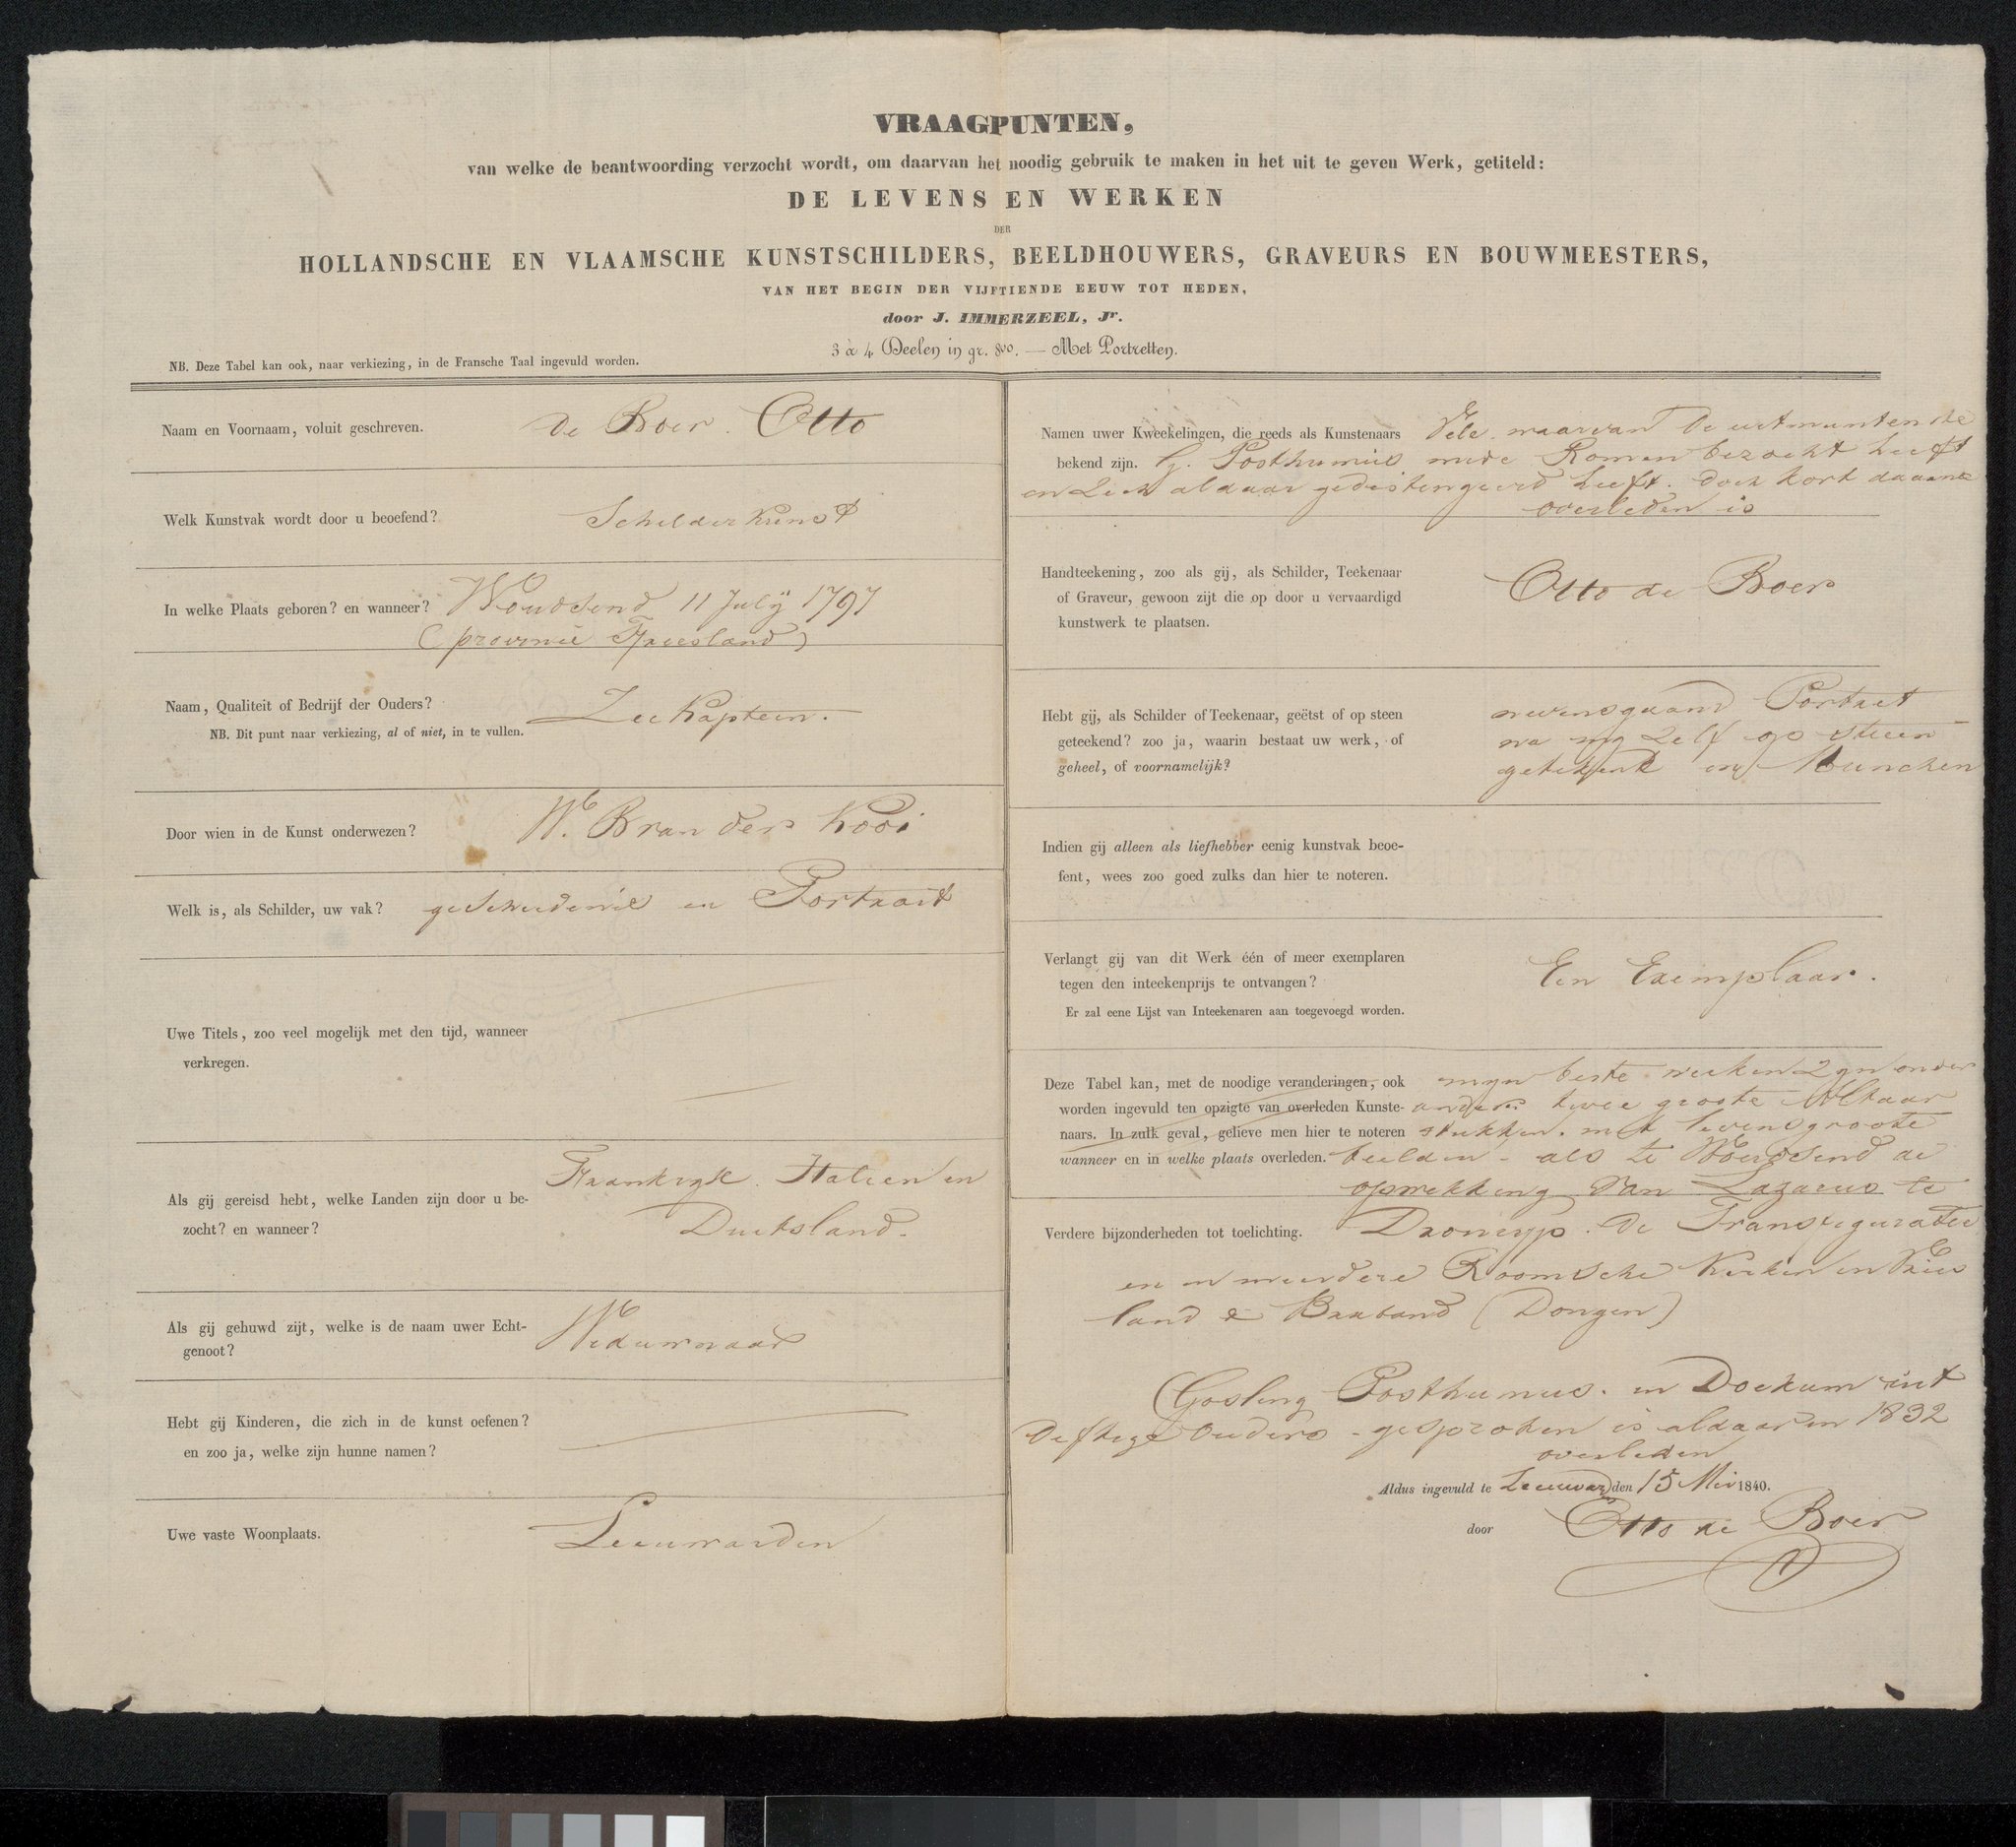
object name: questionnaire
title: Enquêteformulier ingevuld door Otto de Boer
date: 1840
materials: ink, paper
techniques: pen, printing, writing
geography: leeuwarden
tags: painter, draughtsman, otto de boer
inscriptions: inscription: ‘Vraagpunten,/ van welke de beantwoording verzocht wordt, om daarvan het noodig gebruik te maken in het uit te geven Werk, getiteld: De levens en werken/ der Hollandsche en Vlaamsche kunstschilders, beeldhouwers,/ graveurs en bouwmeesters, van het begin der vijftiende eeuw tot heden/ door J. Immerzeel, Jr.’, watermark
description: Opgenomen in: Immerzeel, J. Jr., De levens en werken der Hollandsche en Vlaamsche kunstschilders, beeldhouwers, graveurs en bouwmeesters, van het begin der vijftiende eeuw tot heden, Amsterdam: J.C. van Kesteren, 1842-1843.